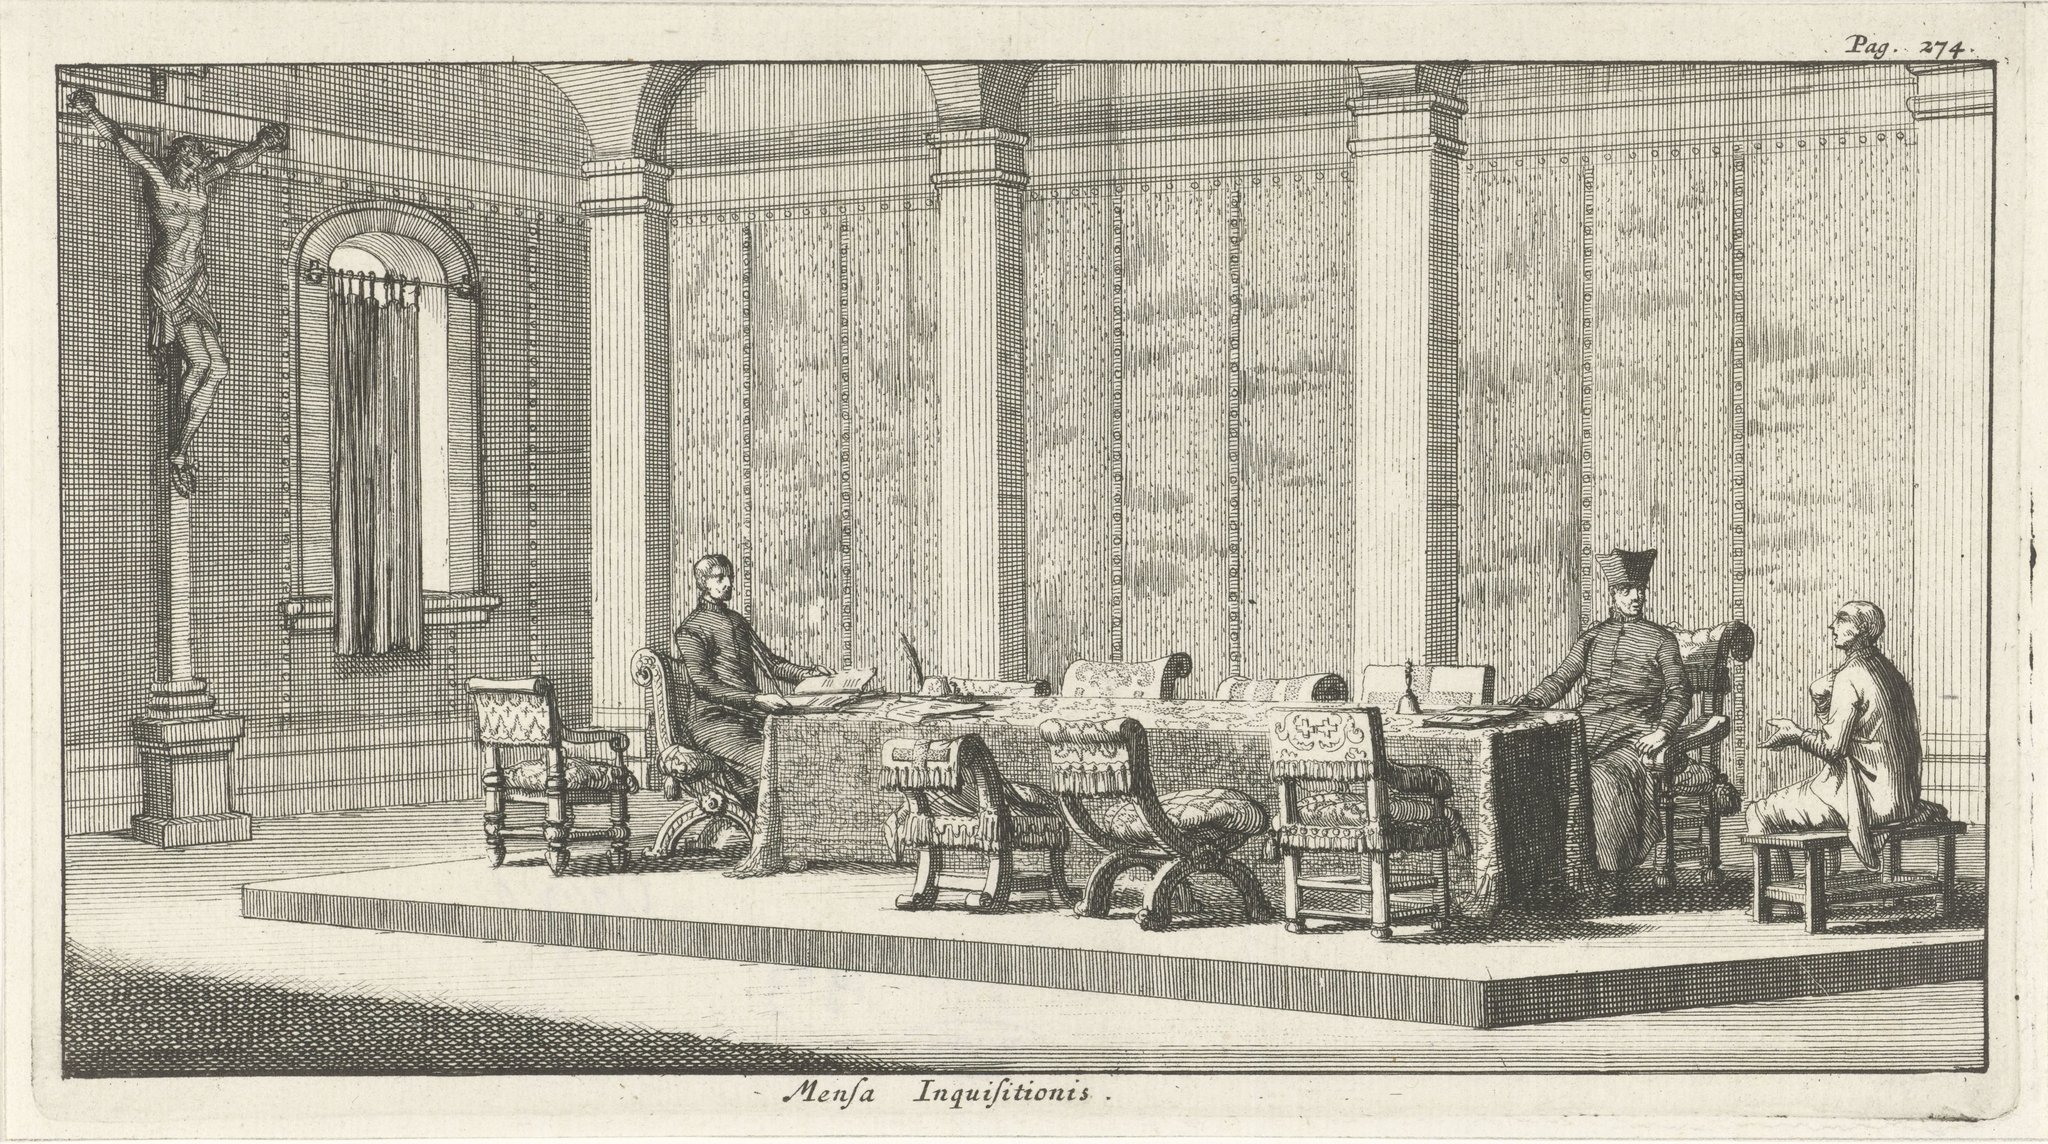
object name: book illustration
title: Mensa Inquisitionis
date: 1692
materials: paper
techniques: etching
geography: amsterdam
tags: the accused, regular clerics, e.g. jesuits, redemptorists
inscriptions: collector's mark: Lugt 2228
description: Illustratie uit: Limborch, Philippus van. Historia inquisitionis. Amsterdam: Henricus Wetstein, 1692.